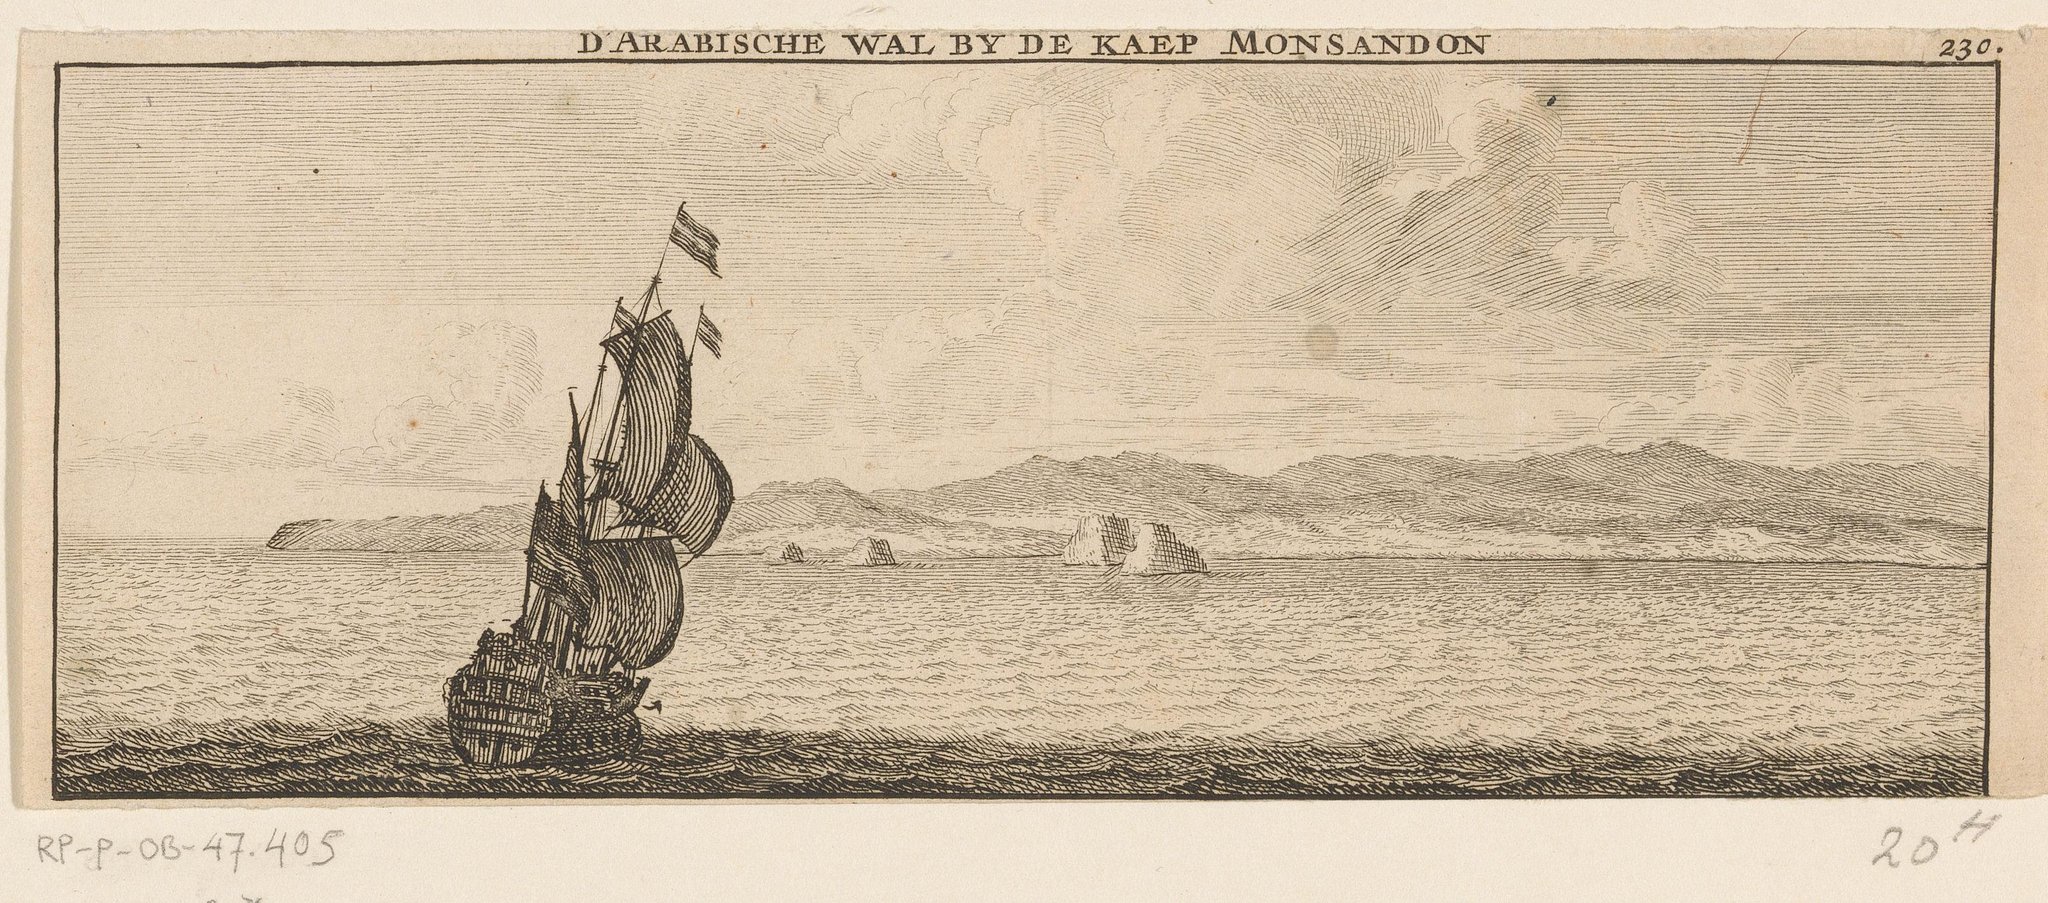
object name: print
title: D'Arabische wal by de Kaep Monsandon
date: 1714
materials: paper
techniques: engraving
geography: amsterdam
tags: gulf, bay, sailing-ship, sailing-boat, landscapes with waters, waterscapes, seascapes (in the temperate zone), persia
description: Fragment van een prent afkomstig uit: Bruin, Cornelis de. Reizen over Moskovie door Persie en Indie. Amsterdam: Rudolph & Gerard Wetstein, Johannes van Oosterwyk, Hendrik van de Gaete, 1714.